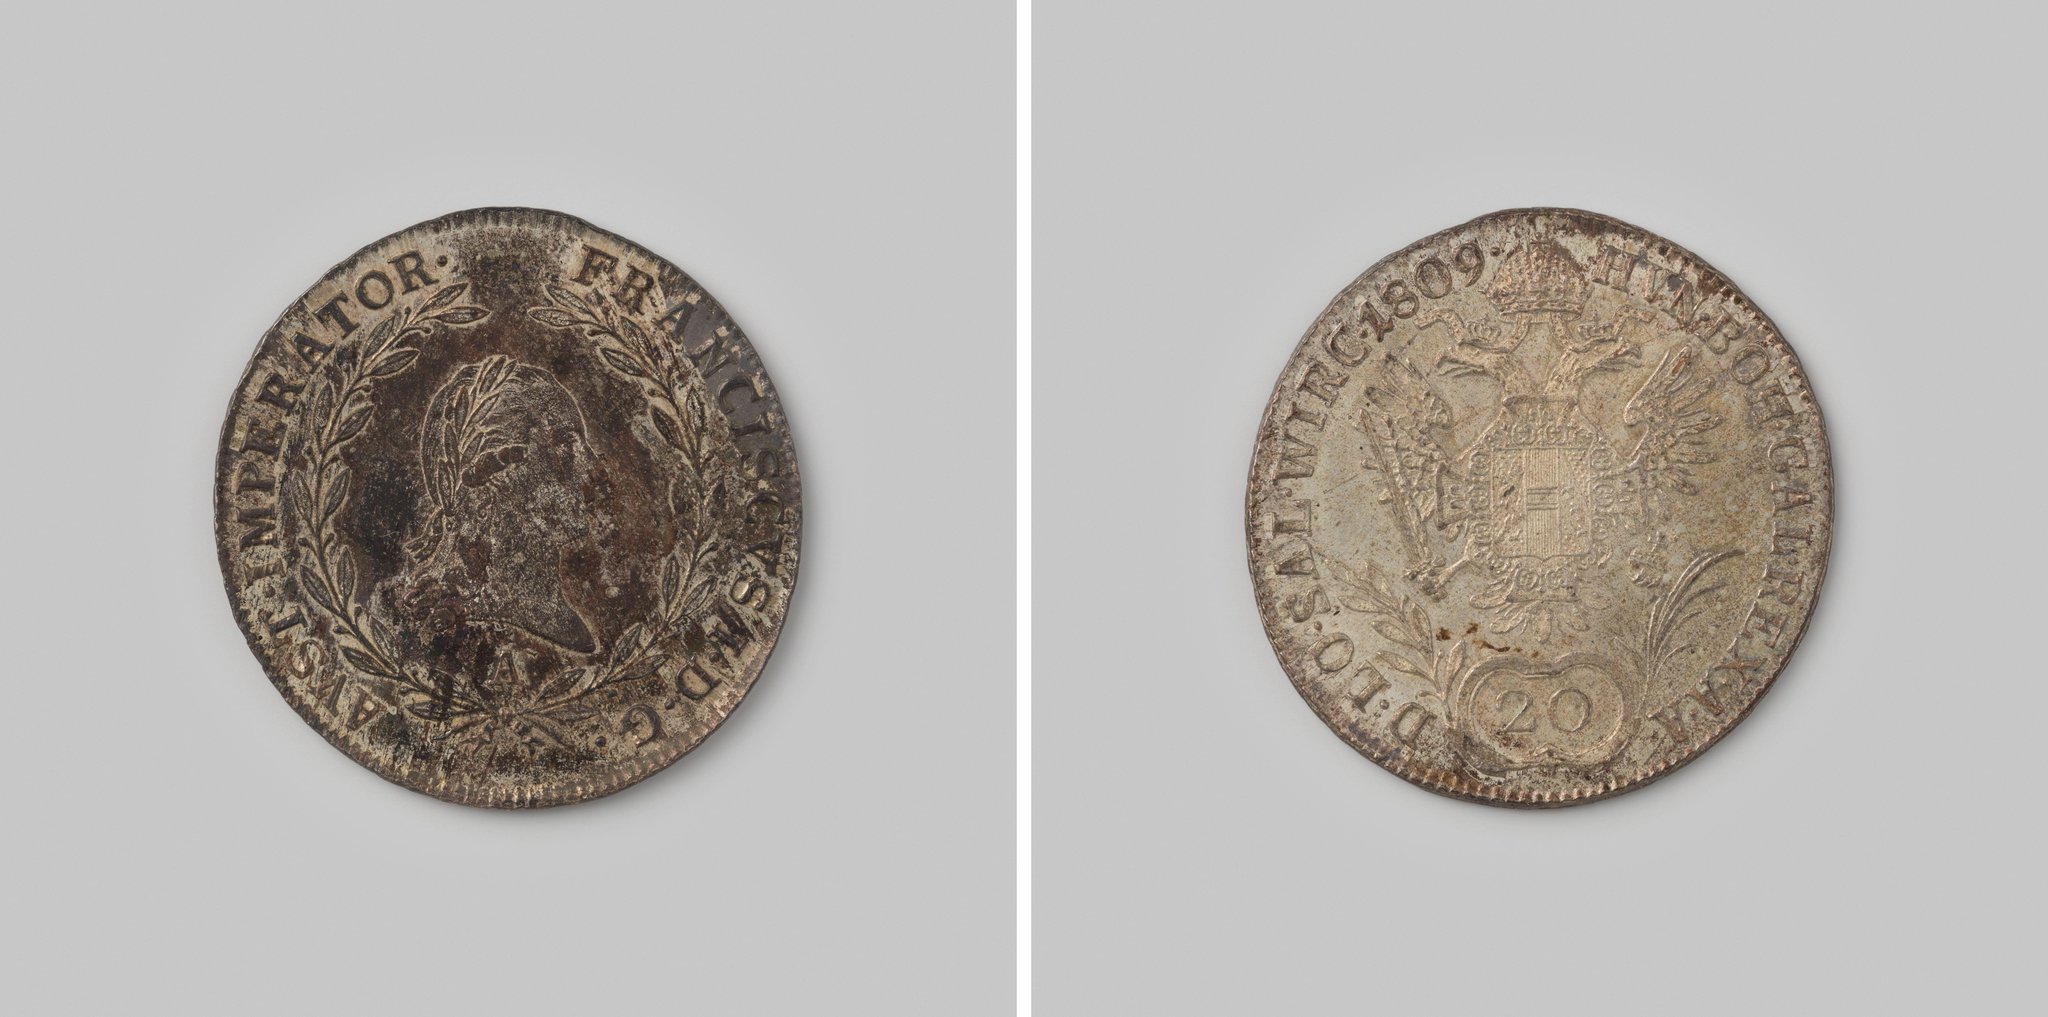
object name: coin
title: Keizerrijk Oostenrijk, 20 kreuzer, Franz I, 1809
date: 1809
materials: silver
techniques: striking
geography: vienna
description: Zilveren munt. Voorzijde: binnen twee samengebonden takken gelauwerd hoofd van de keizer naar rechts, waaronder letter A [=Wenen]. Keerzijde: gekroonde dubbelkoppige adelaar met op de koppen kleine kronen. Op zijn borst door ridderorde omhangen samengesteld wapenschild en in zijn poten een zwaard en een rijksappel. Daaronder binnen versiering waarde-aanduiding. Jaartal aan het eind van het omschrift. Kabelrand.